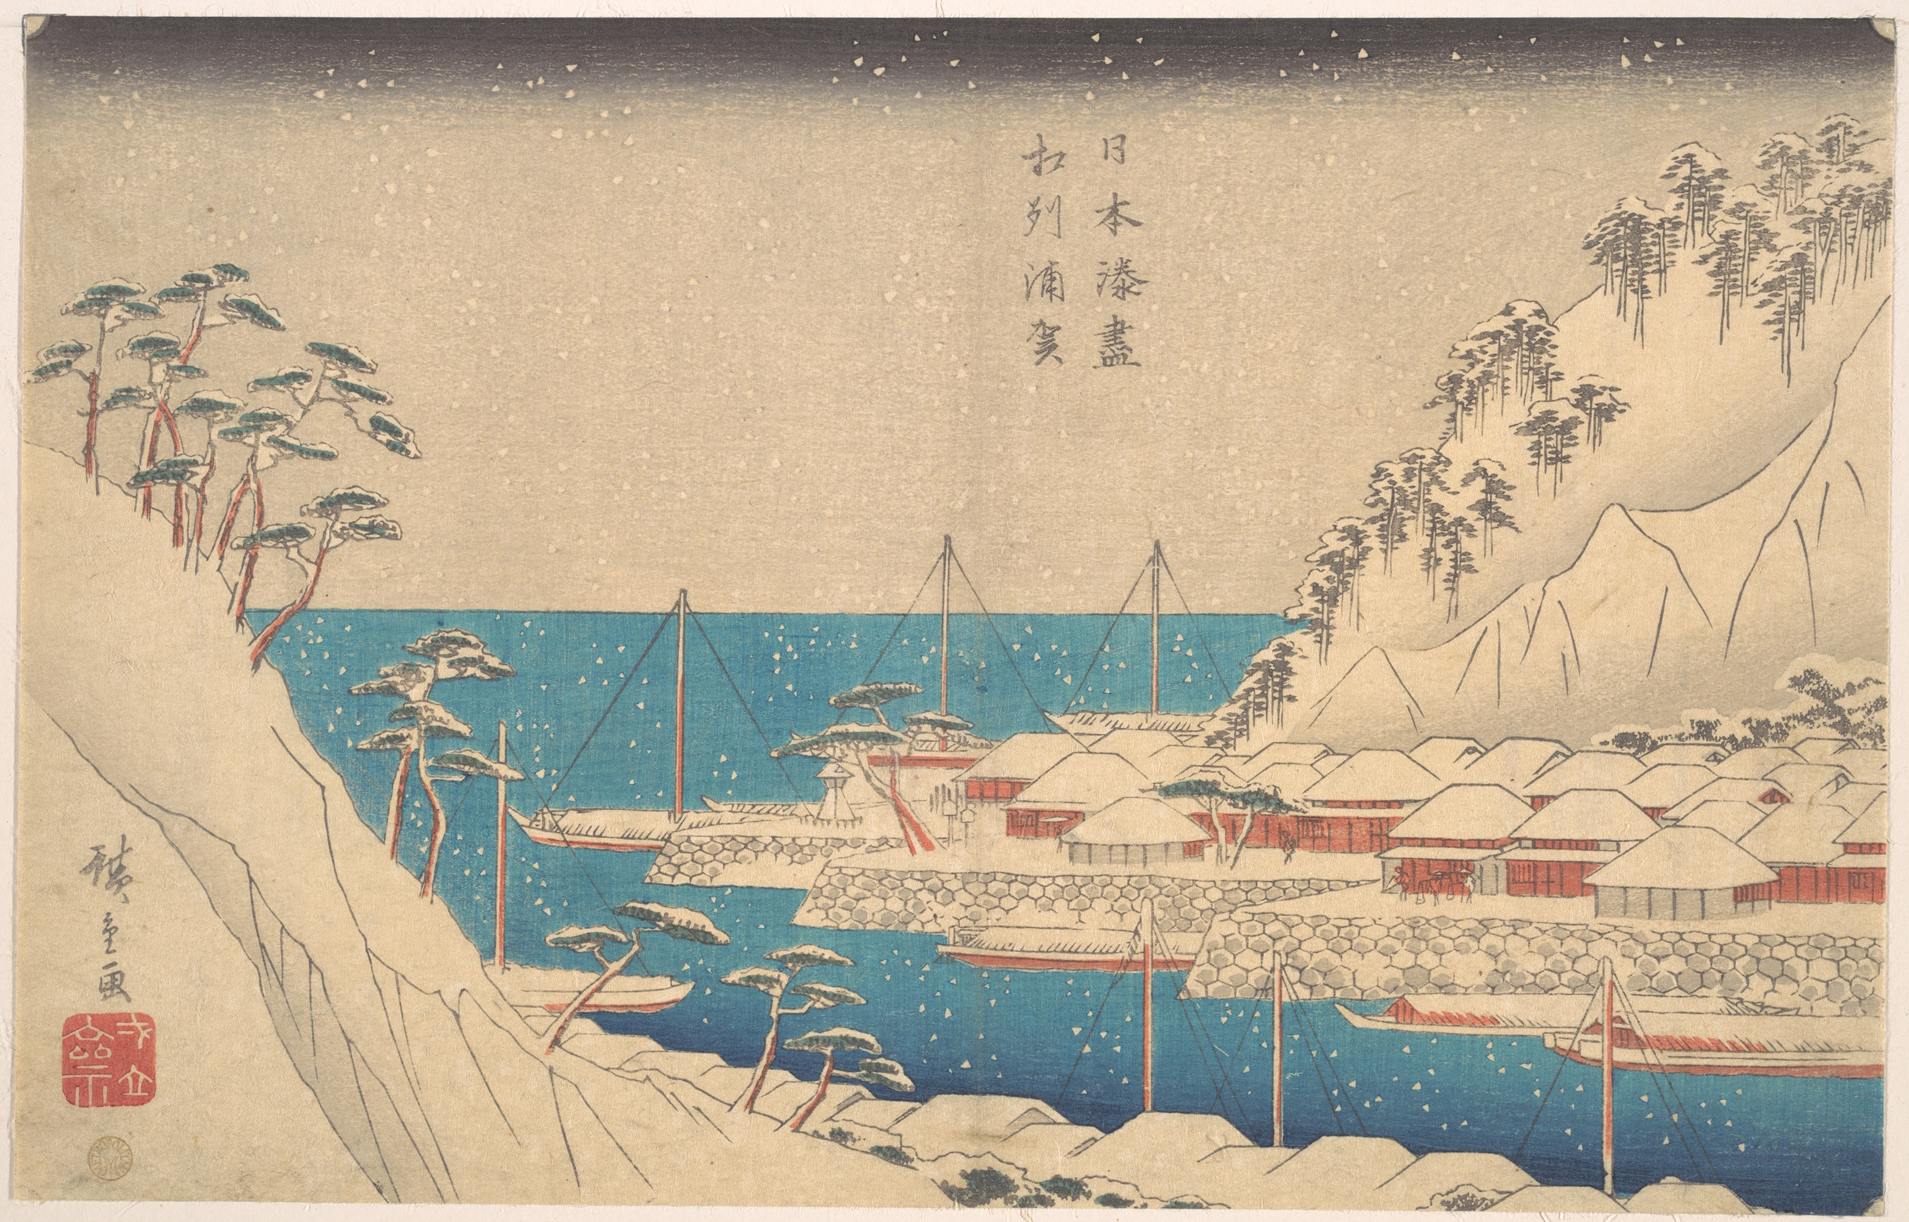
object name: print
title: Uraga Harbor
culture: japanese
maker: utagawa hiroshige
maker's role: artist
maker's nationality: japanese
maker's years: 1797-1858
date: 1837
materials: ink, paper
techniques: woodblock print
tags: mountains,boats,harbors